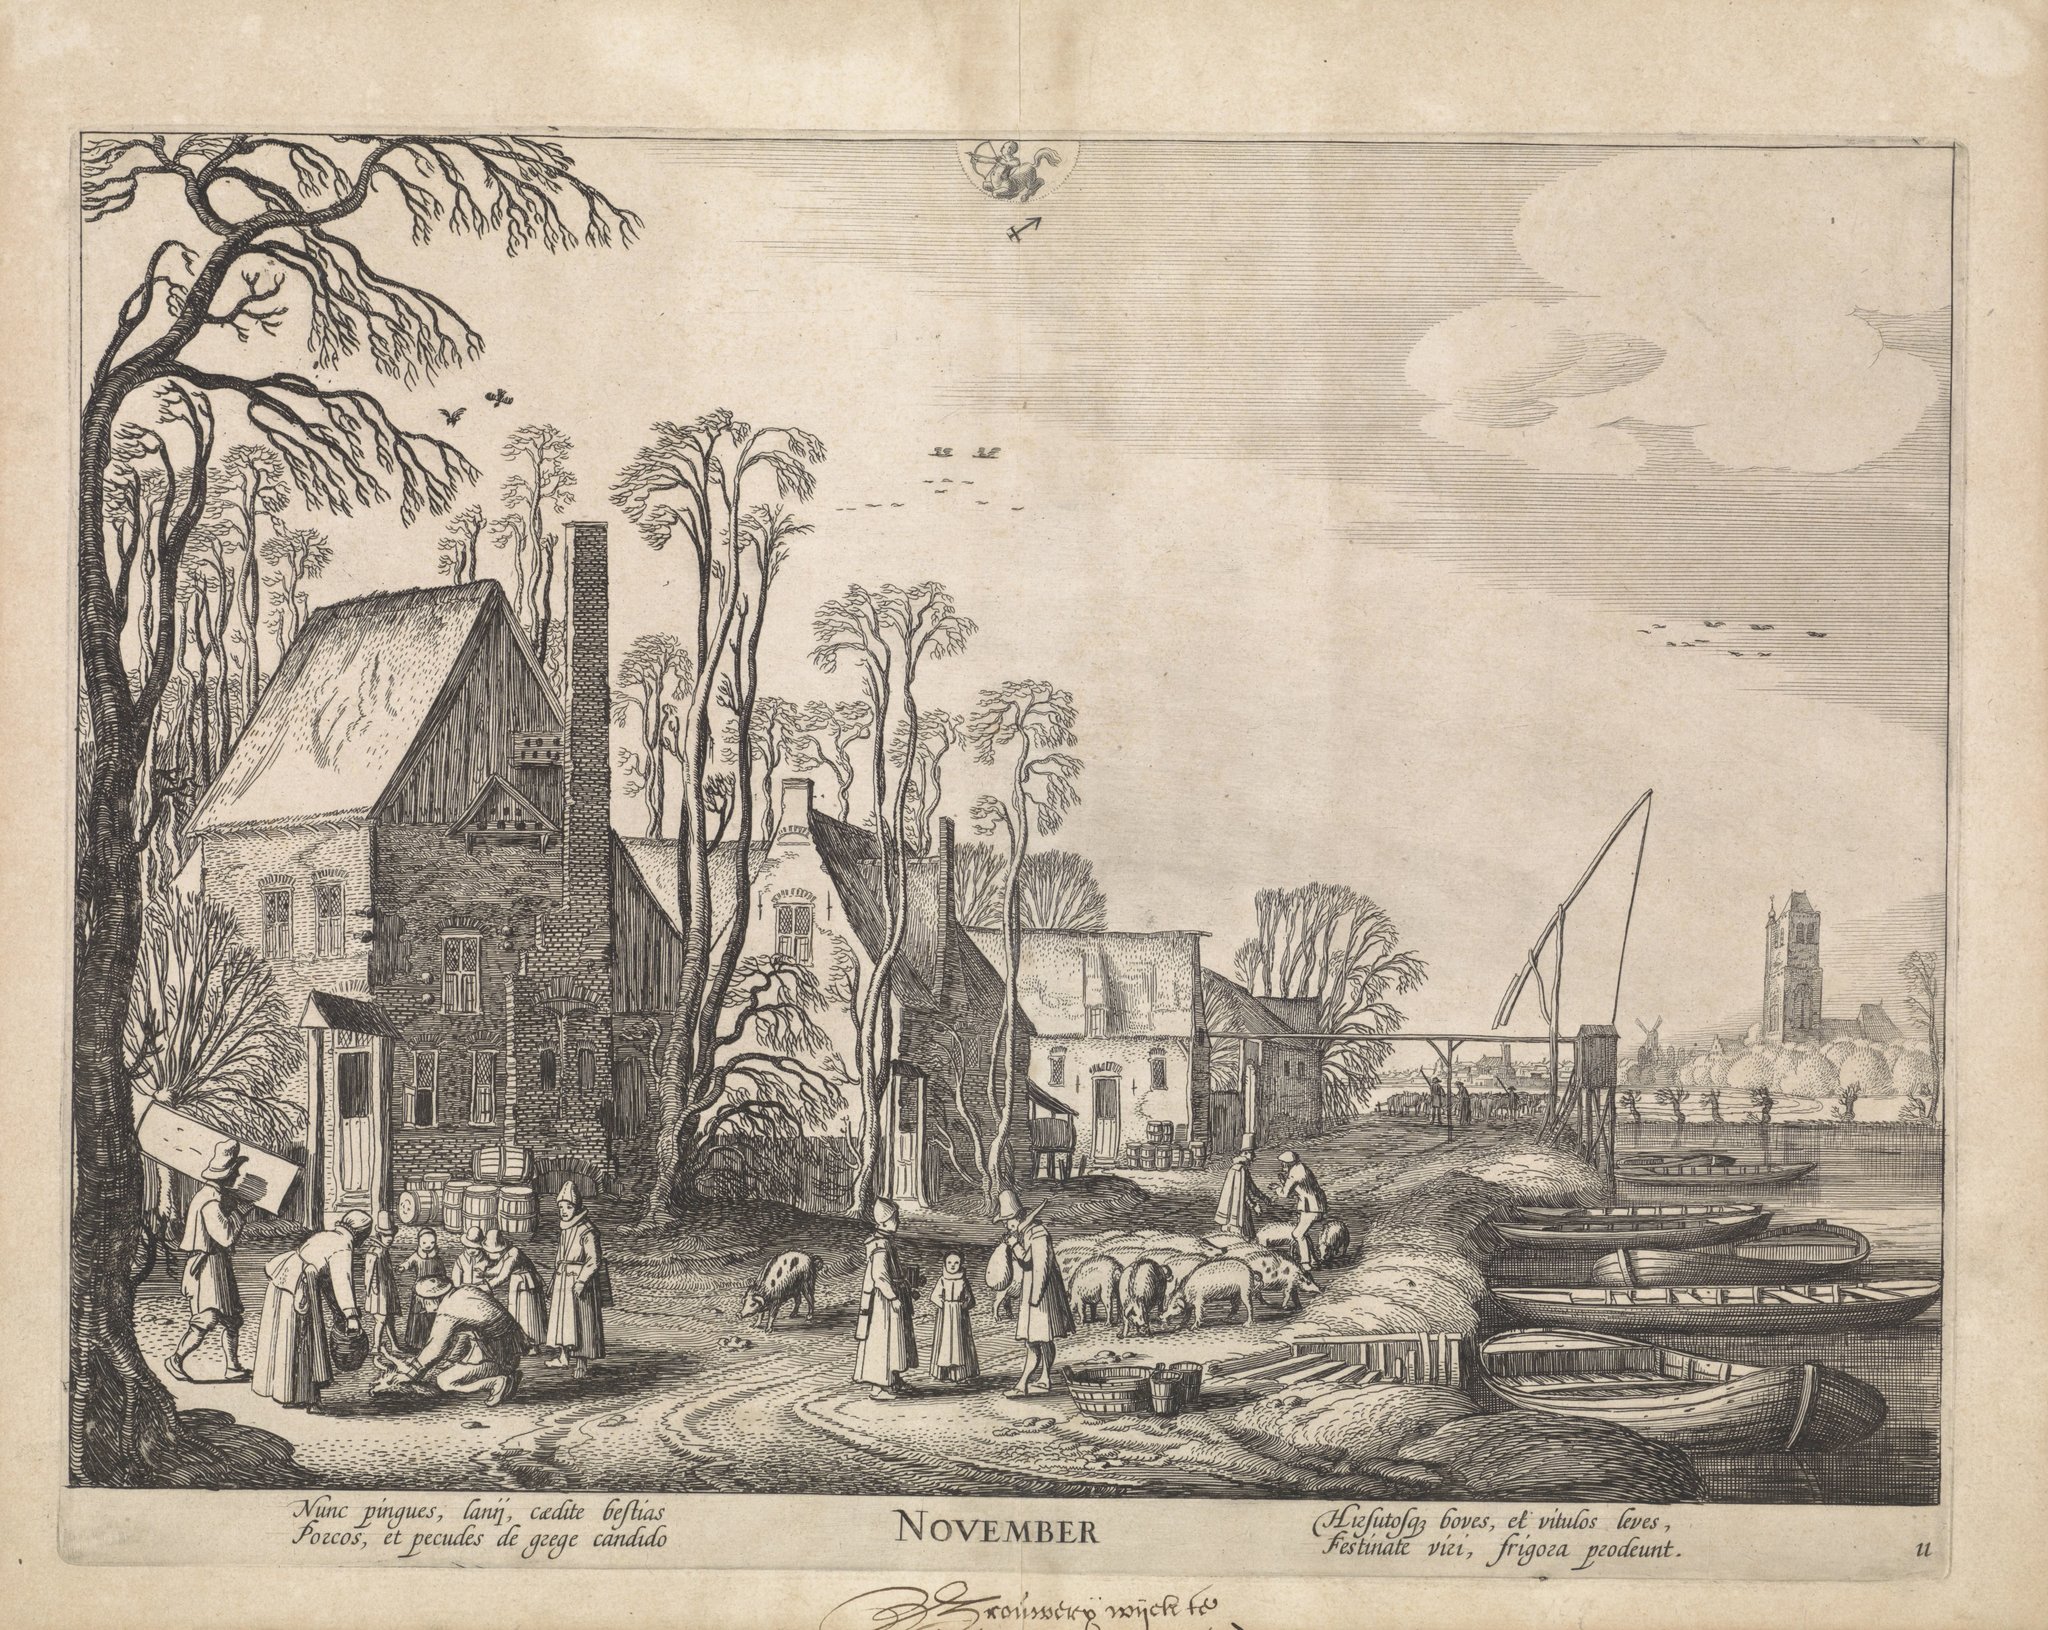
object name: print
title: November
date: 1618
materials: paper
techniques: etching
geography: northern netherlands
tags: landscape symbolizing november, pig, brewer (+ place ~ crafts, industries, agriculture), november and its 'labours', sagittarius (zodiacal sign of november), butcher, slaughterman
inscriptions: collector's mark: Lugt 2228, caption: ‘Brouwery wyck te [...]’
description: Landschap met vele figuren op een landweg waaronder een varkenshoeder met zijn kudde bij een dorp langs een rivier; voorstellende de maand november. Links wordt een varken geslacht voor een brouwerij. Langs de weg nog een brouwerij. Bovenaan het bij deze maand behorende sterrenbeeld: boogschutter. Elfde prent uit een serie van twaalf.